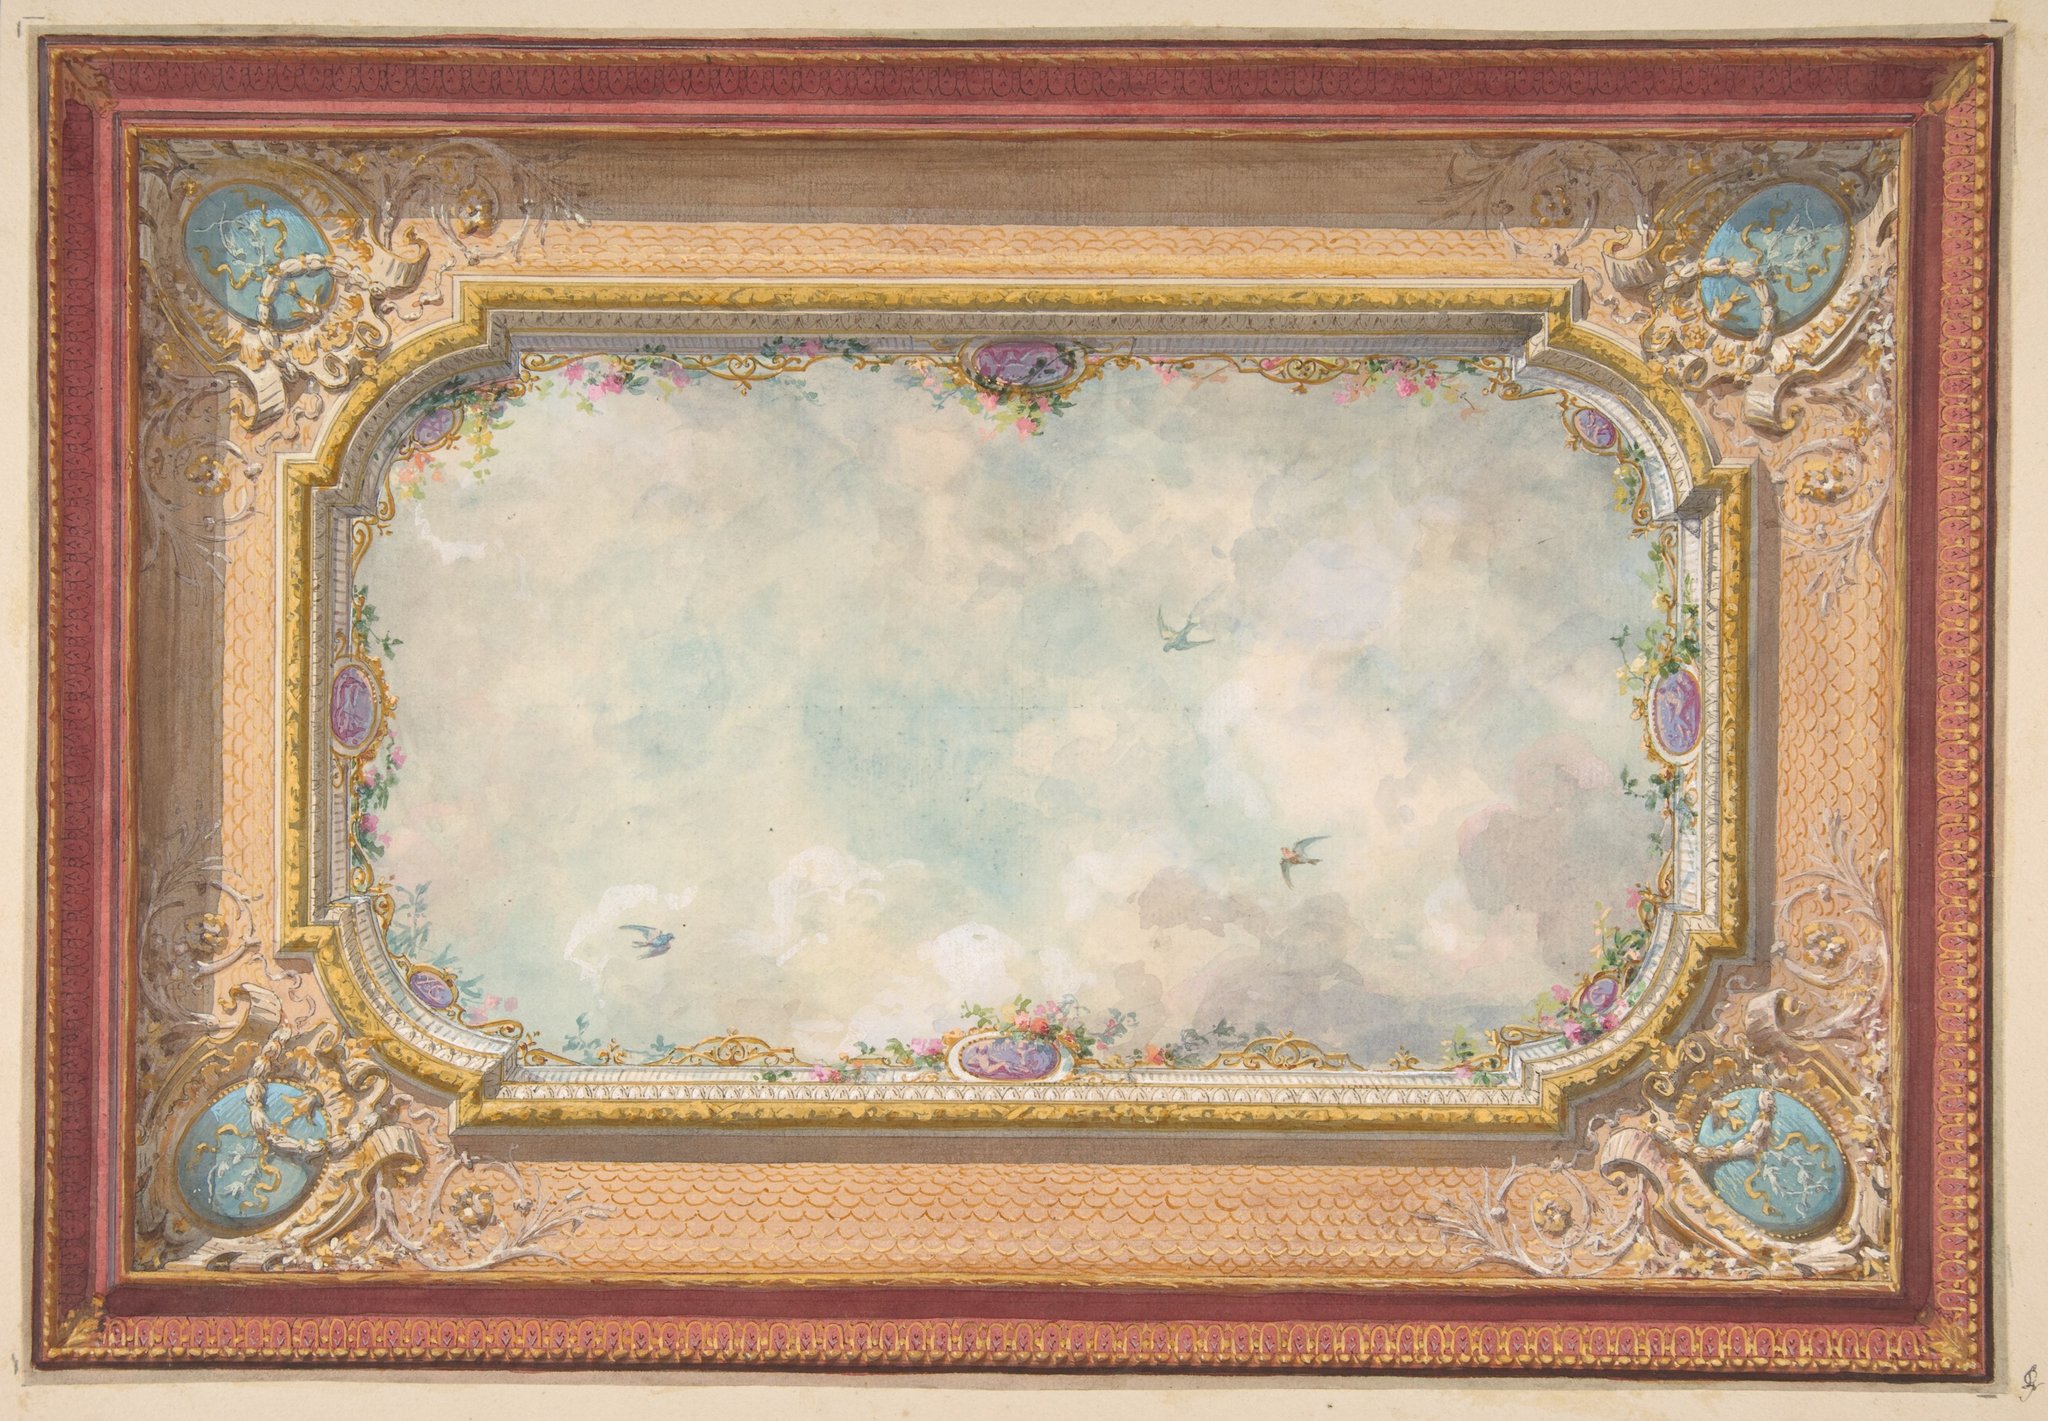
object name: drawing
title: Design for a ceiling with trompe l'oeil sky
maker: jules-edmond-charles lachaise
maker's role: artist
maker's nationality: french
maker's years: 1897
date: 1851-1900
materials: gouache, graphite, watercolor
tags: birds,sky,flowers